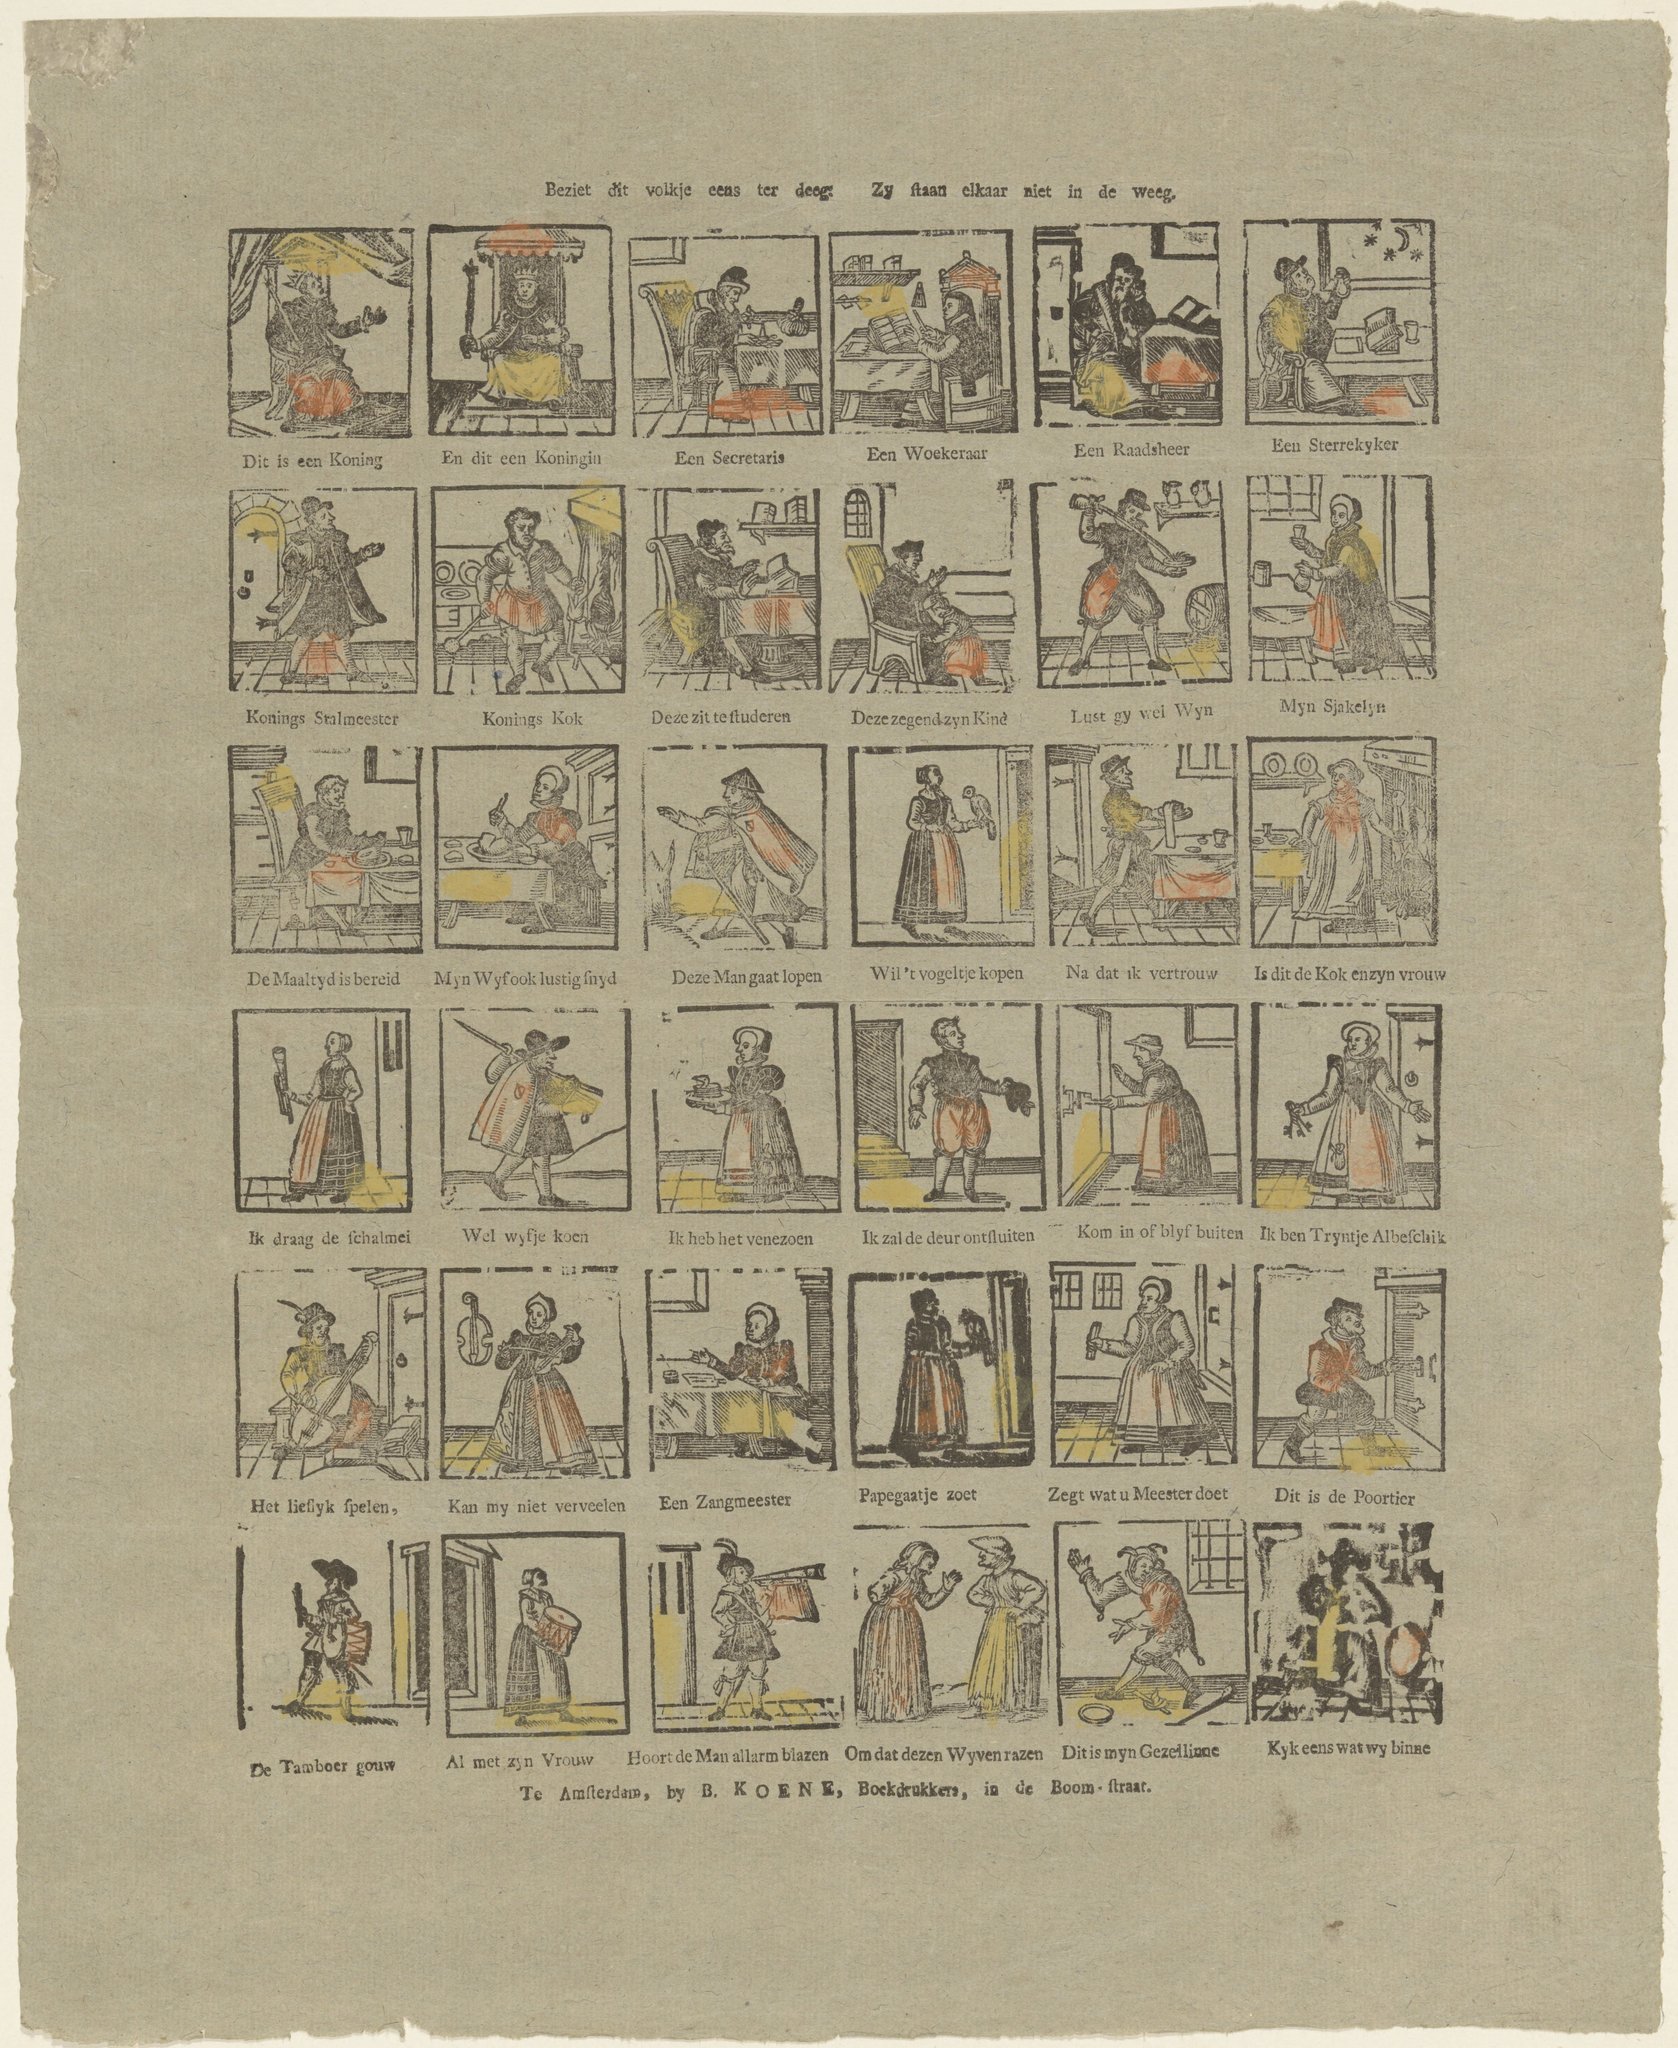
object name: popular print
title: Beziet dit volkje eens ter deeg / Zy staan elkaar niet in de weeg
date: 1814-1830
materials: paper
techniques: colour, letterpress printing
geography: netherlands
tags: street-trader, crafts and industries, nobility and patriciate; chivalry, knighthood, merchant, salesman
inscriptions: collector's mark: Lugt 2760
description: Blad met 36 voorstellingen van verschillende figuren en beroepen, waaronder een koning, een vogel verkoopster en een tamboer. Onder elke voorstelling een onderschrift.